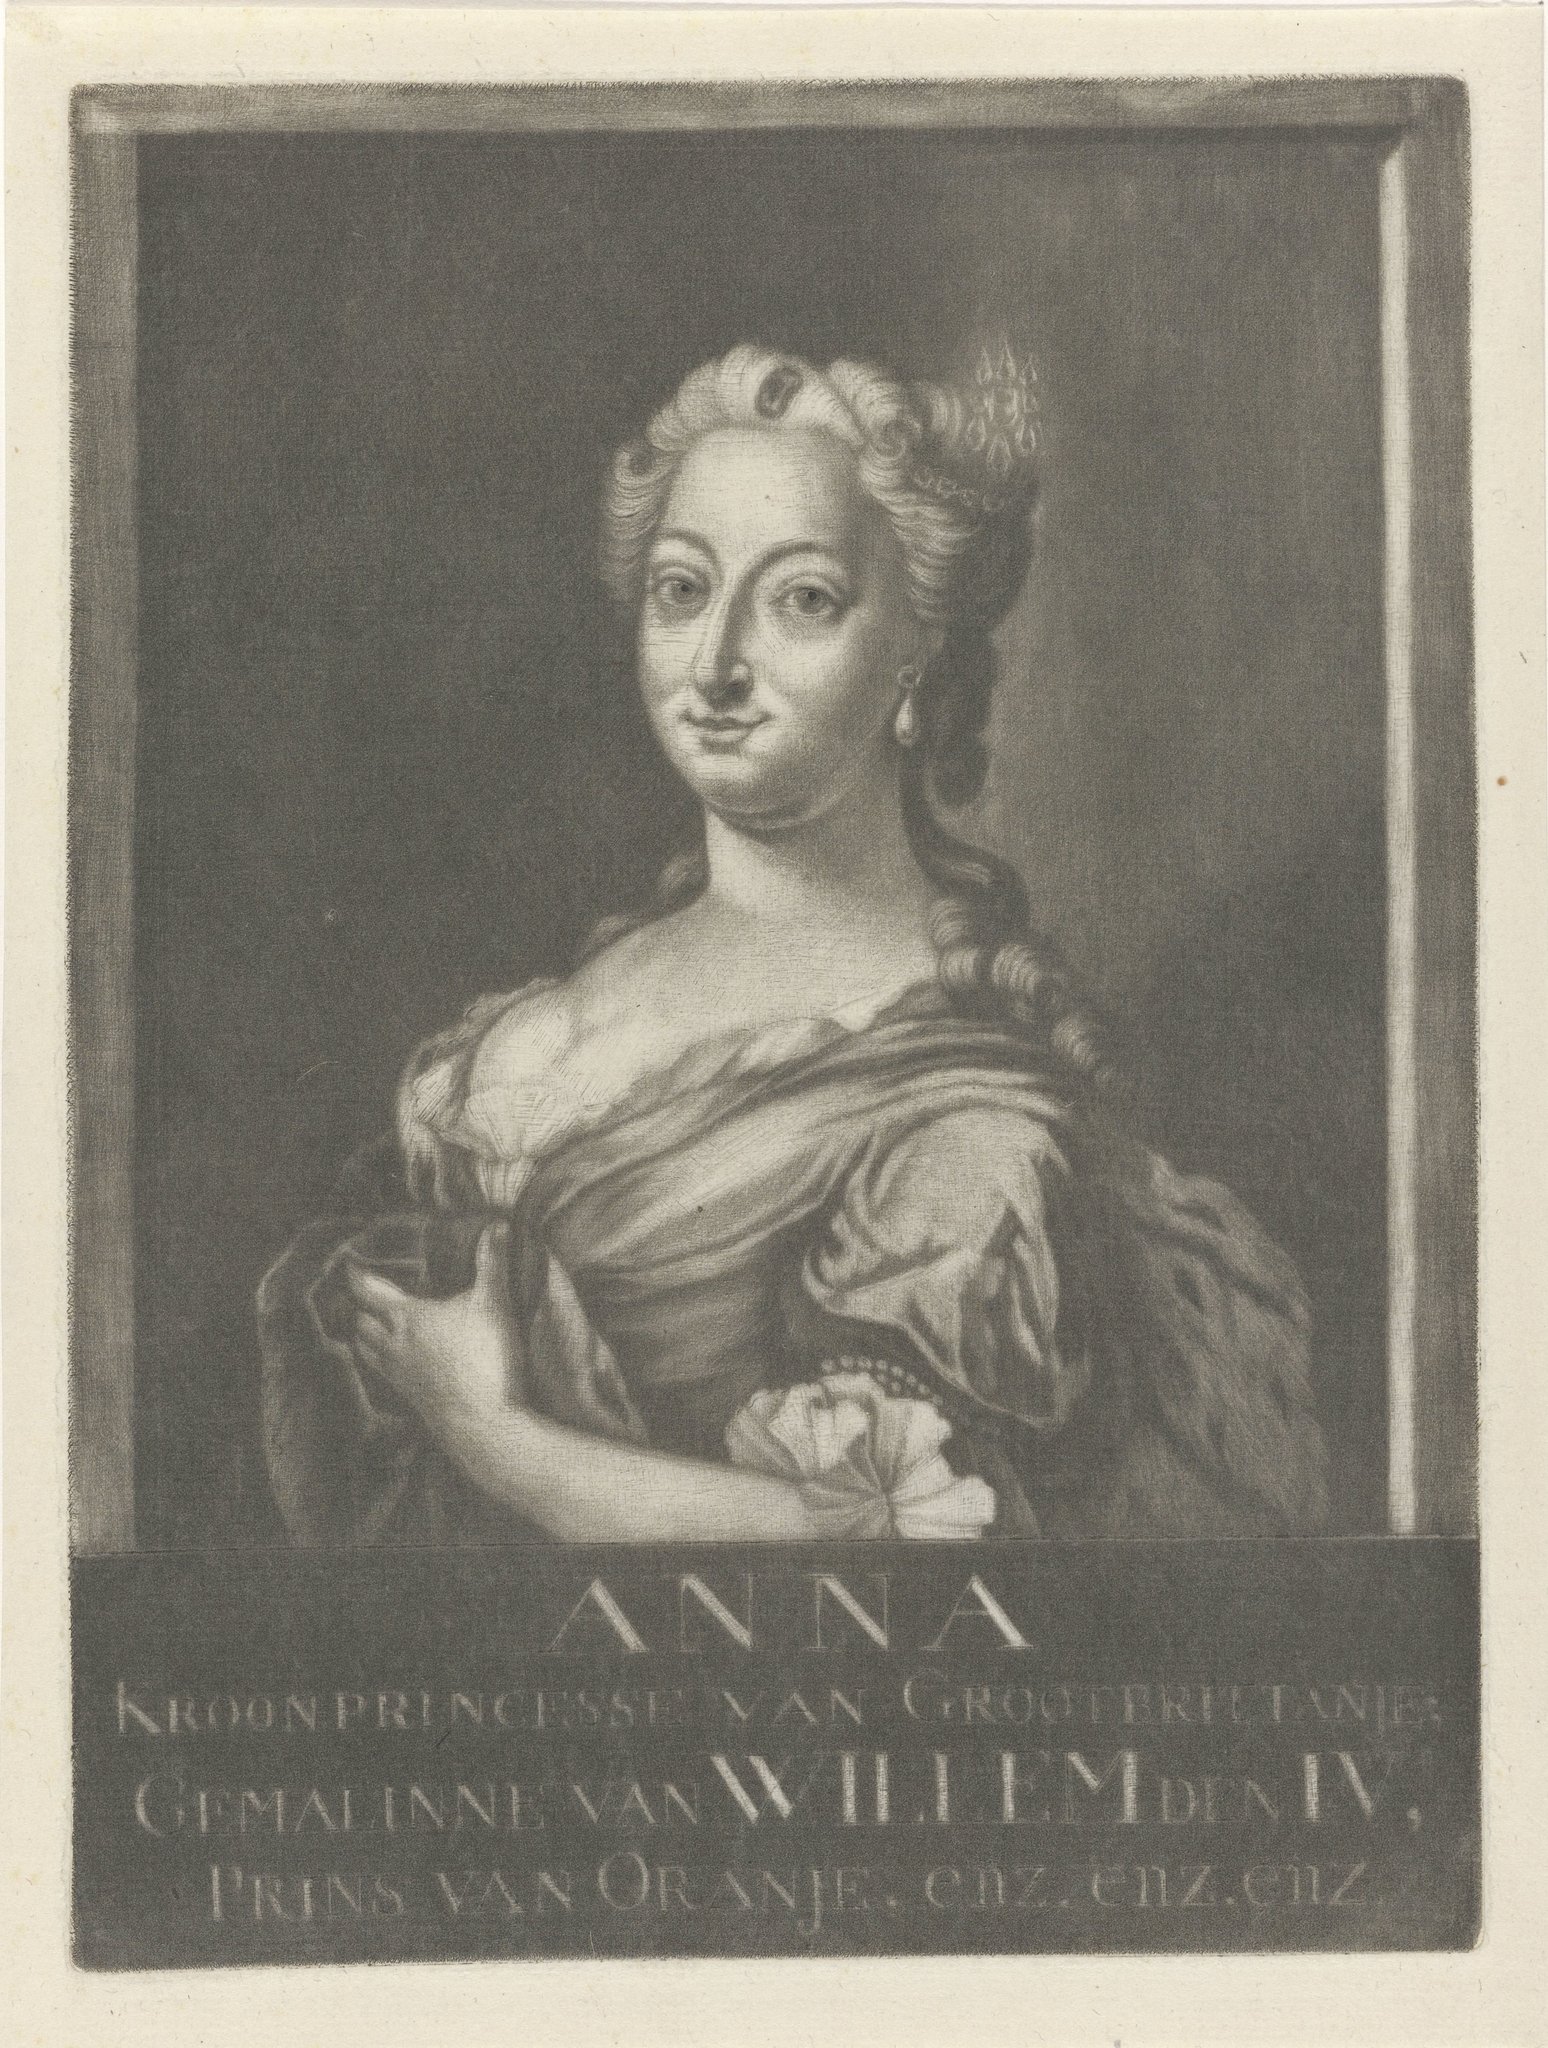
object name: print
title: Portret van Anna van Hannover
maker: rienk jelgerhuis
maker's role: draughtsman, print maker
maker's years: 1729-1806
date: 1770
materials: paper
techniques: mezzotint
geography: leeuwarden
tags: the hague, anna van hannover, pearl; pearl necklace (+ women's clothes)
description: Ook gebruikt als illustratie in: Bosch, Johannes van den. De heeren stadhouderen van Vriesland, zedert den jare acht-hondert. Leeuwarden: Abraham Ferwerda en G.Tresling, 1770.